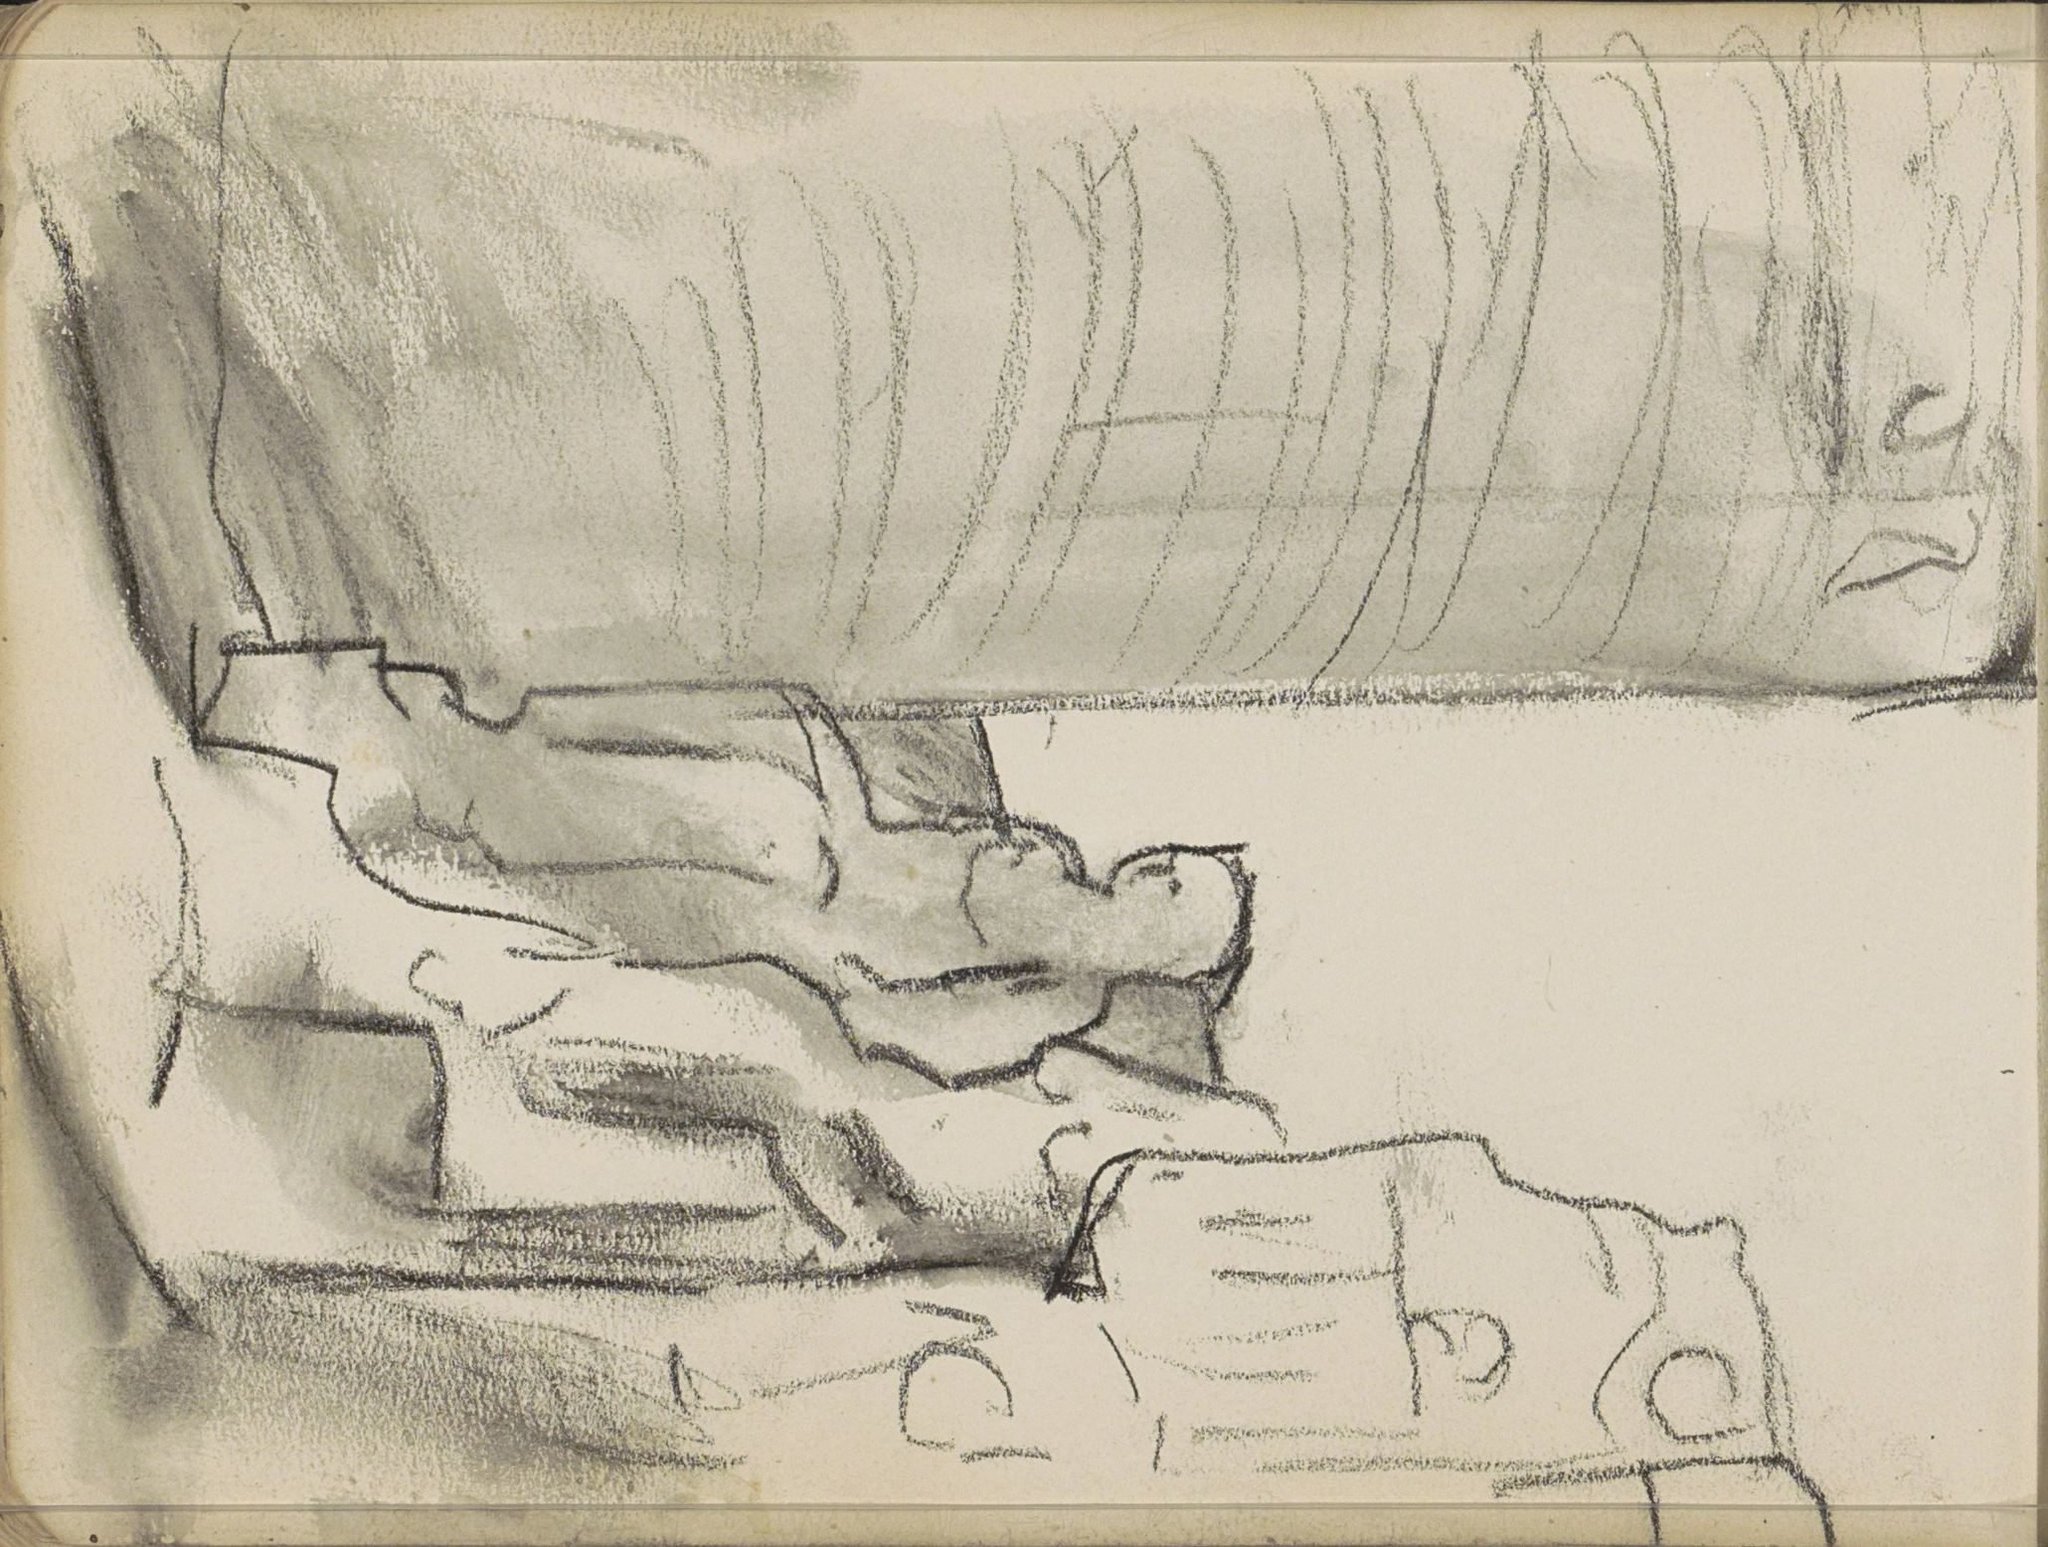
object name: sketchbook leaf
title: Beeldhouwwerk van een zittende god bij de Luxortempel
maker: marius bauer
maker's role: draughtsman, print maker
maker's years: 1867-1932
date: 1919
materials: chalk, paper, watercolor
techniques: brush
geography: luxor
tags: temple, shrine ~ egyptian religion, sculpture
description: Pagina 37 uit een schetsboek met 28 bladen.